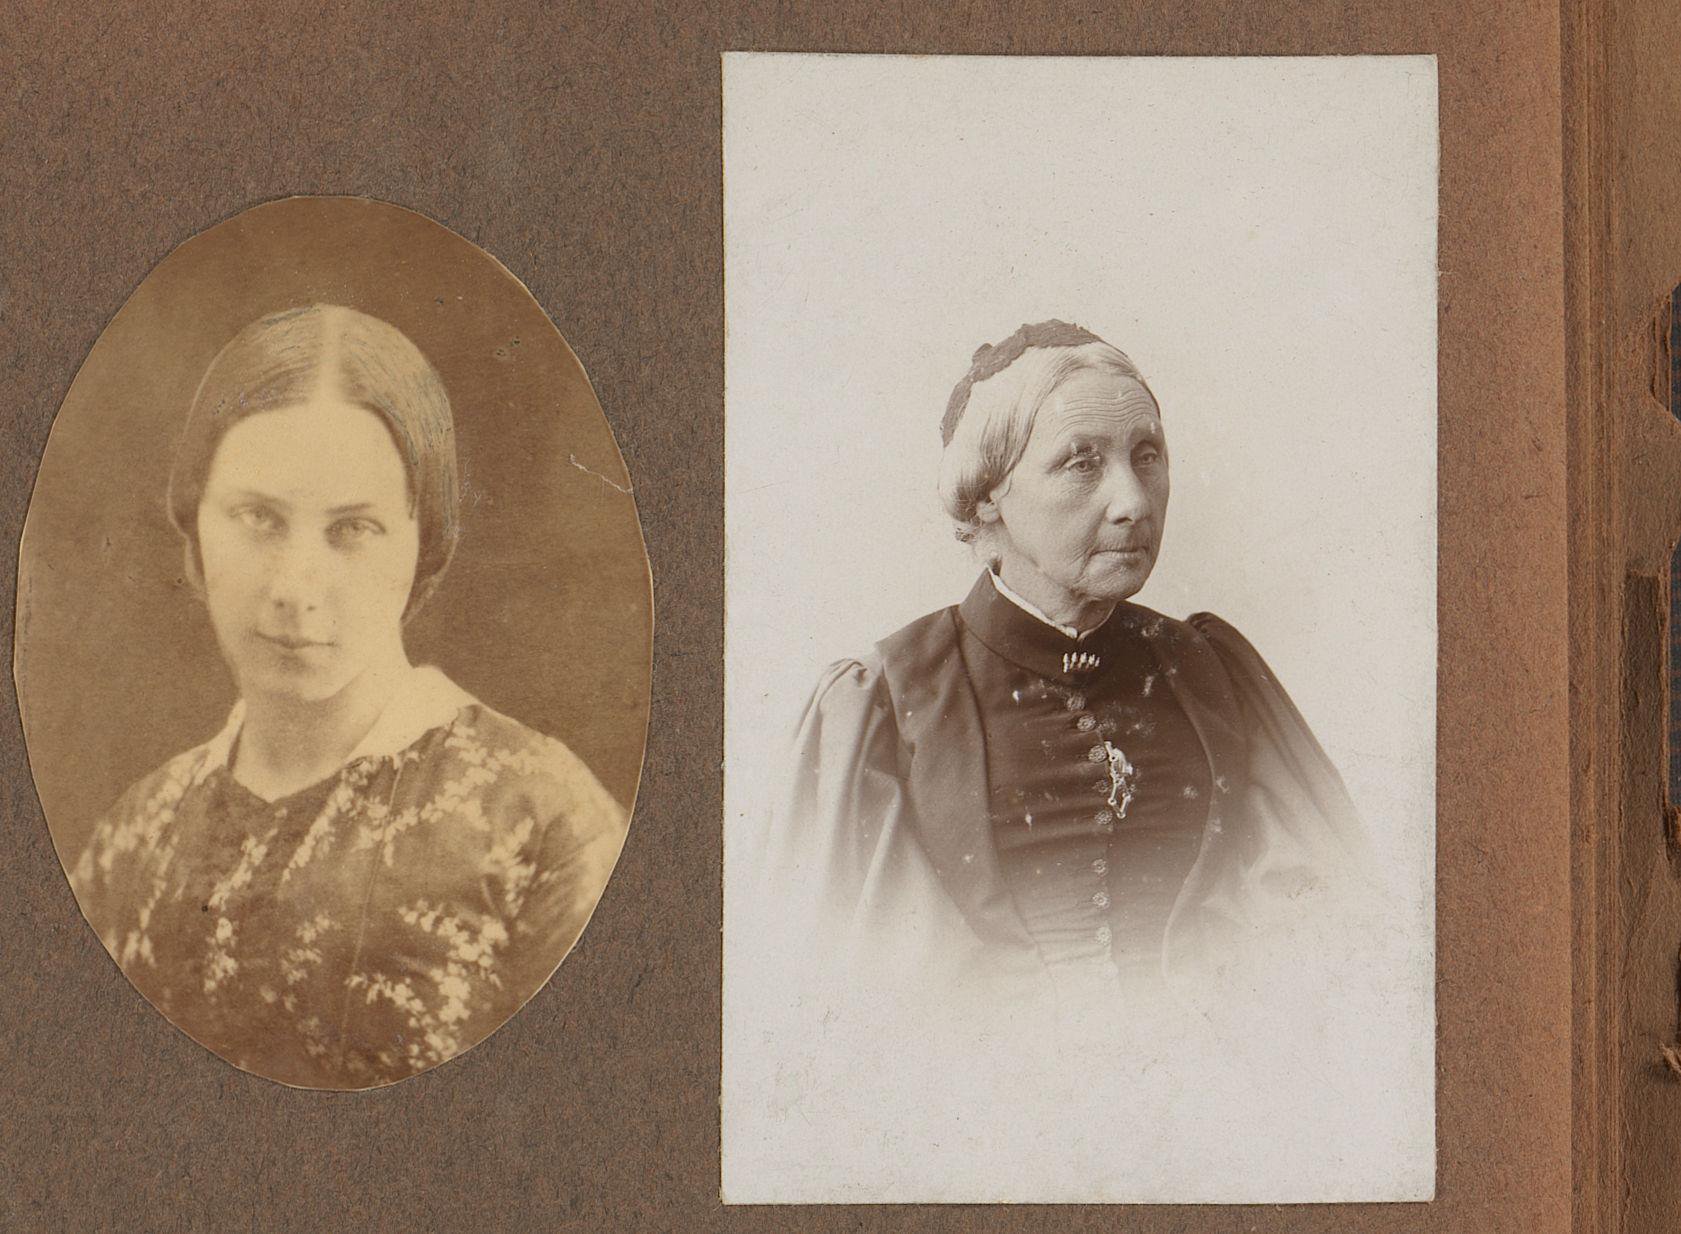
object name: photograph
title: Portret van vrouw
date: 1880-1910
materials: photographic support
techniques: photography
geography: netherlands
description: Foto op bruin albumblad 29 van familiealbum van Alphons Diepenbrock.